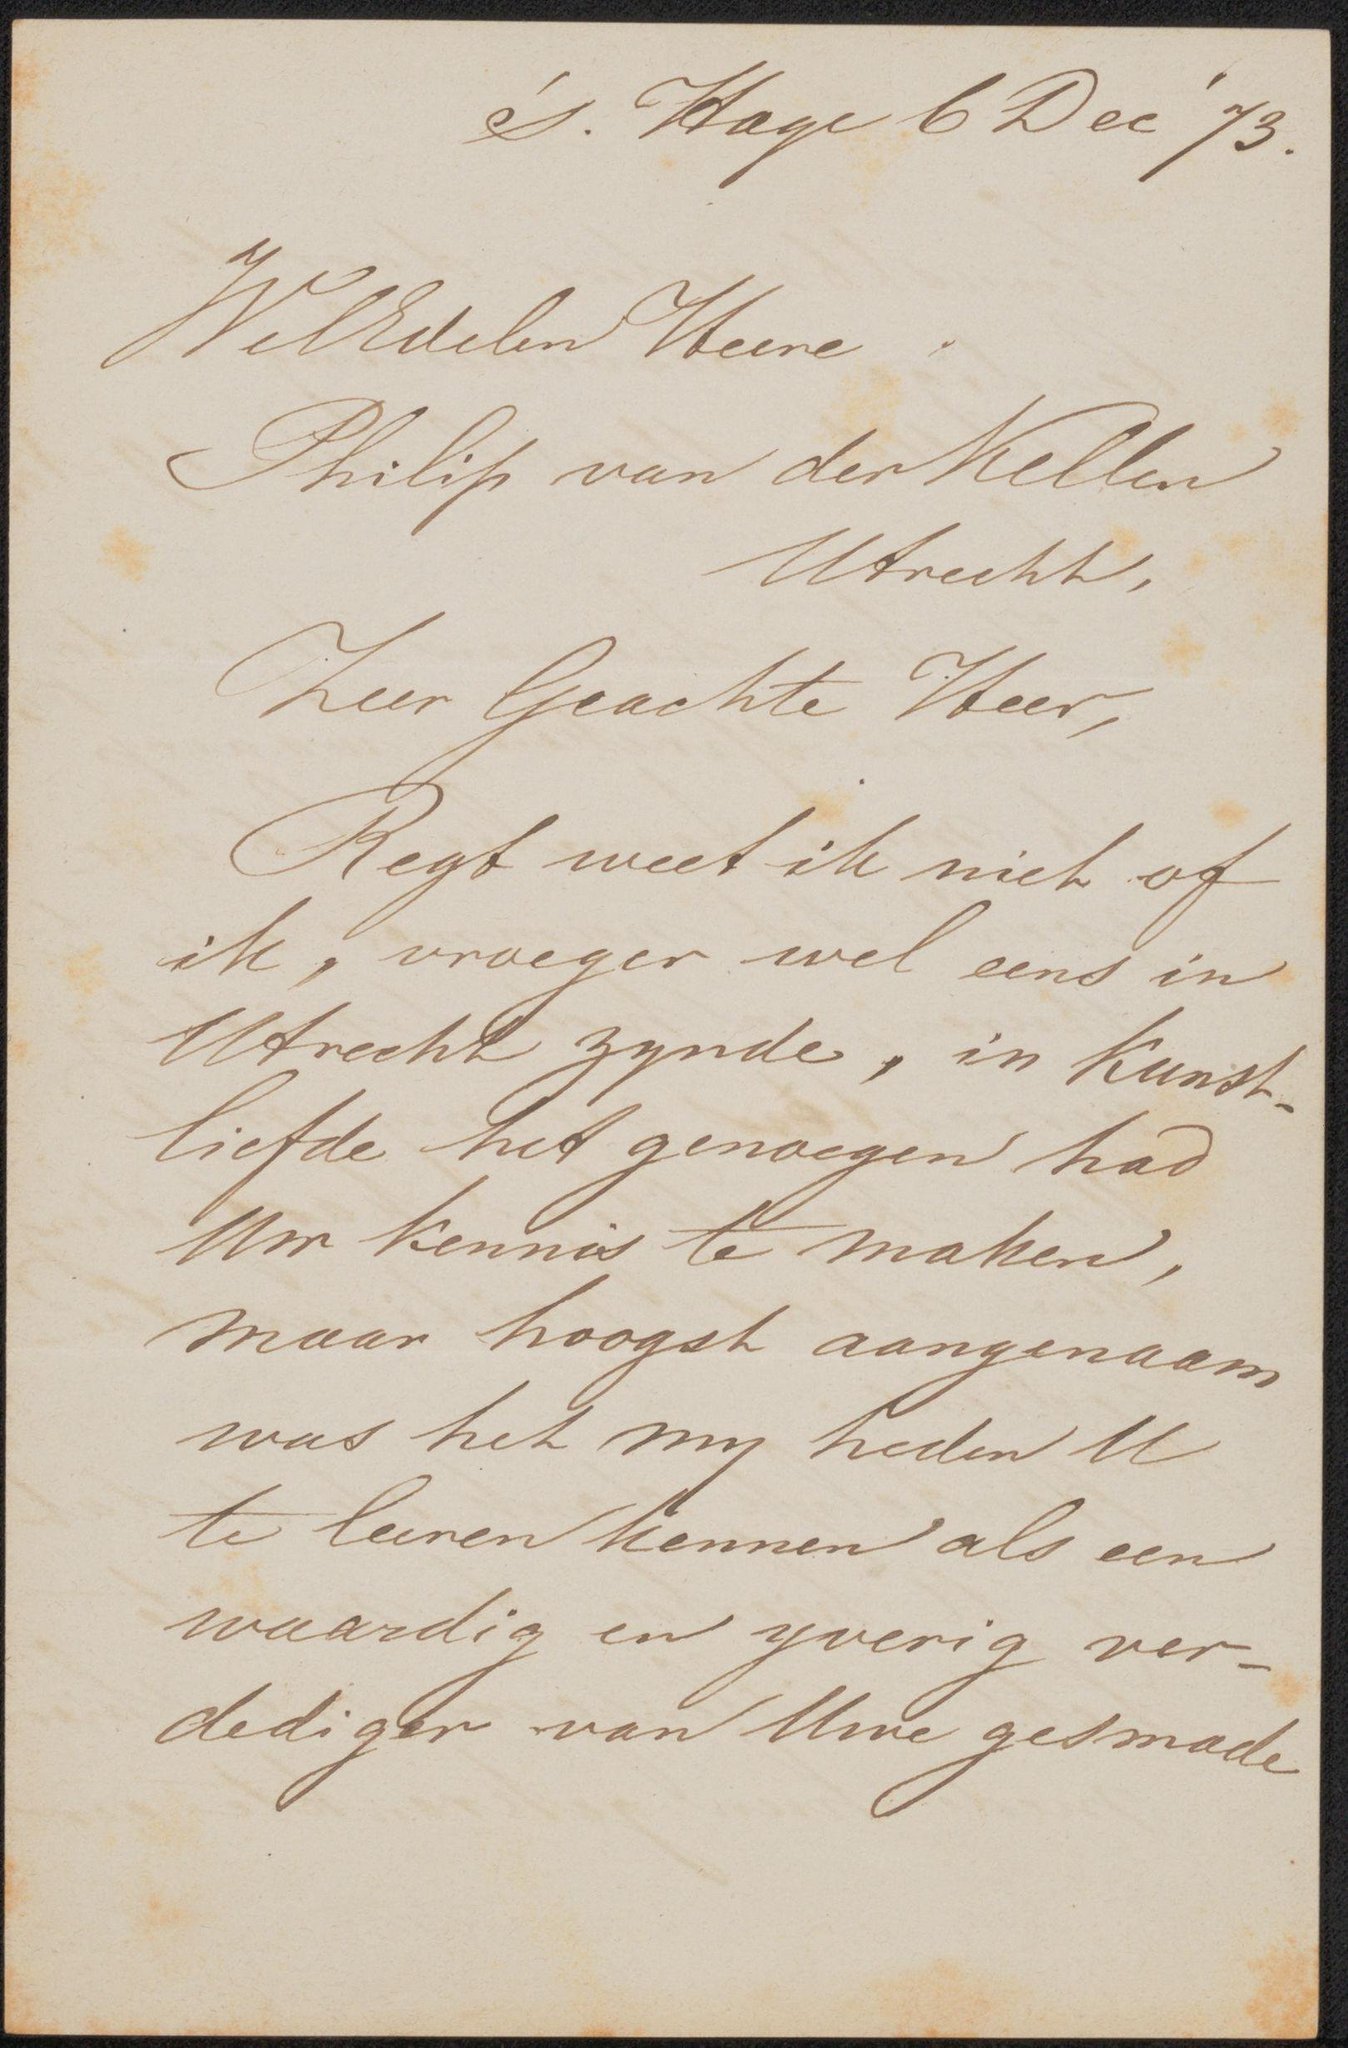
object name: letter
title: Brief aan Johan Philip van der Kellen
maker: willem carel nakken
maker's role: draughtsman, painter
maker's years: 1835-1926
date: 1873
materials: ink, paper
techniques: pen, writing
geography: the hague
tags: utrecht, print maker, draughtsman, johan philip van der kellen, criticizing and discussing art, art criticism, distribution of awards ~ art contest